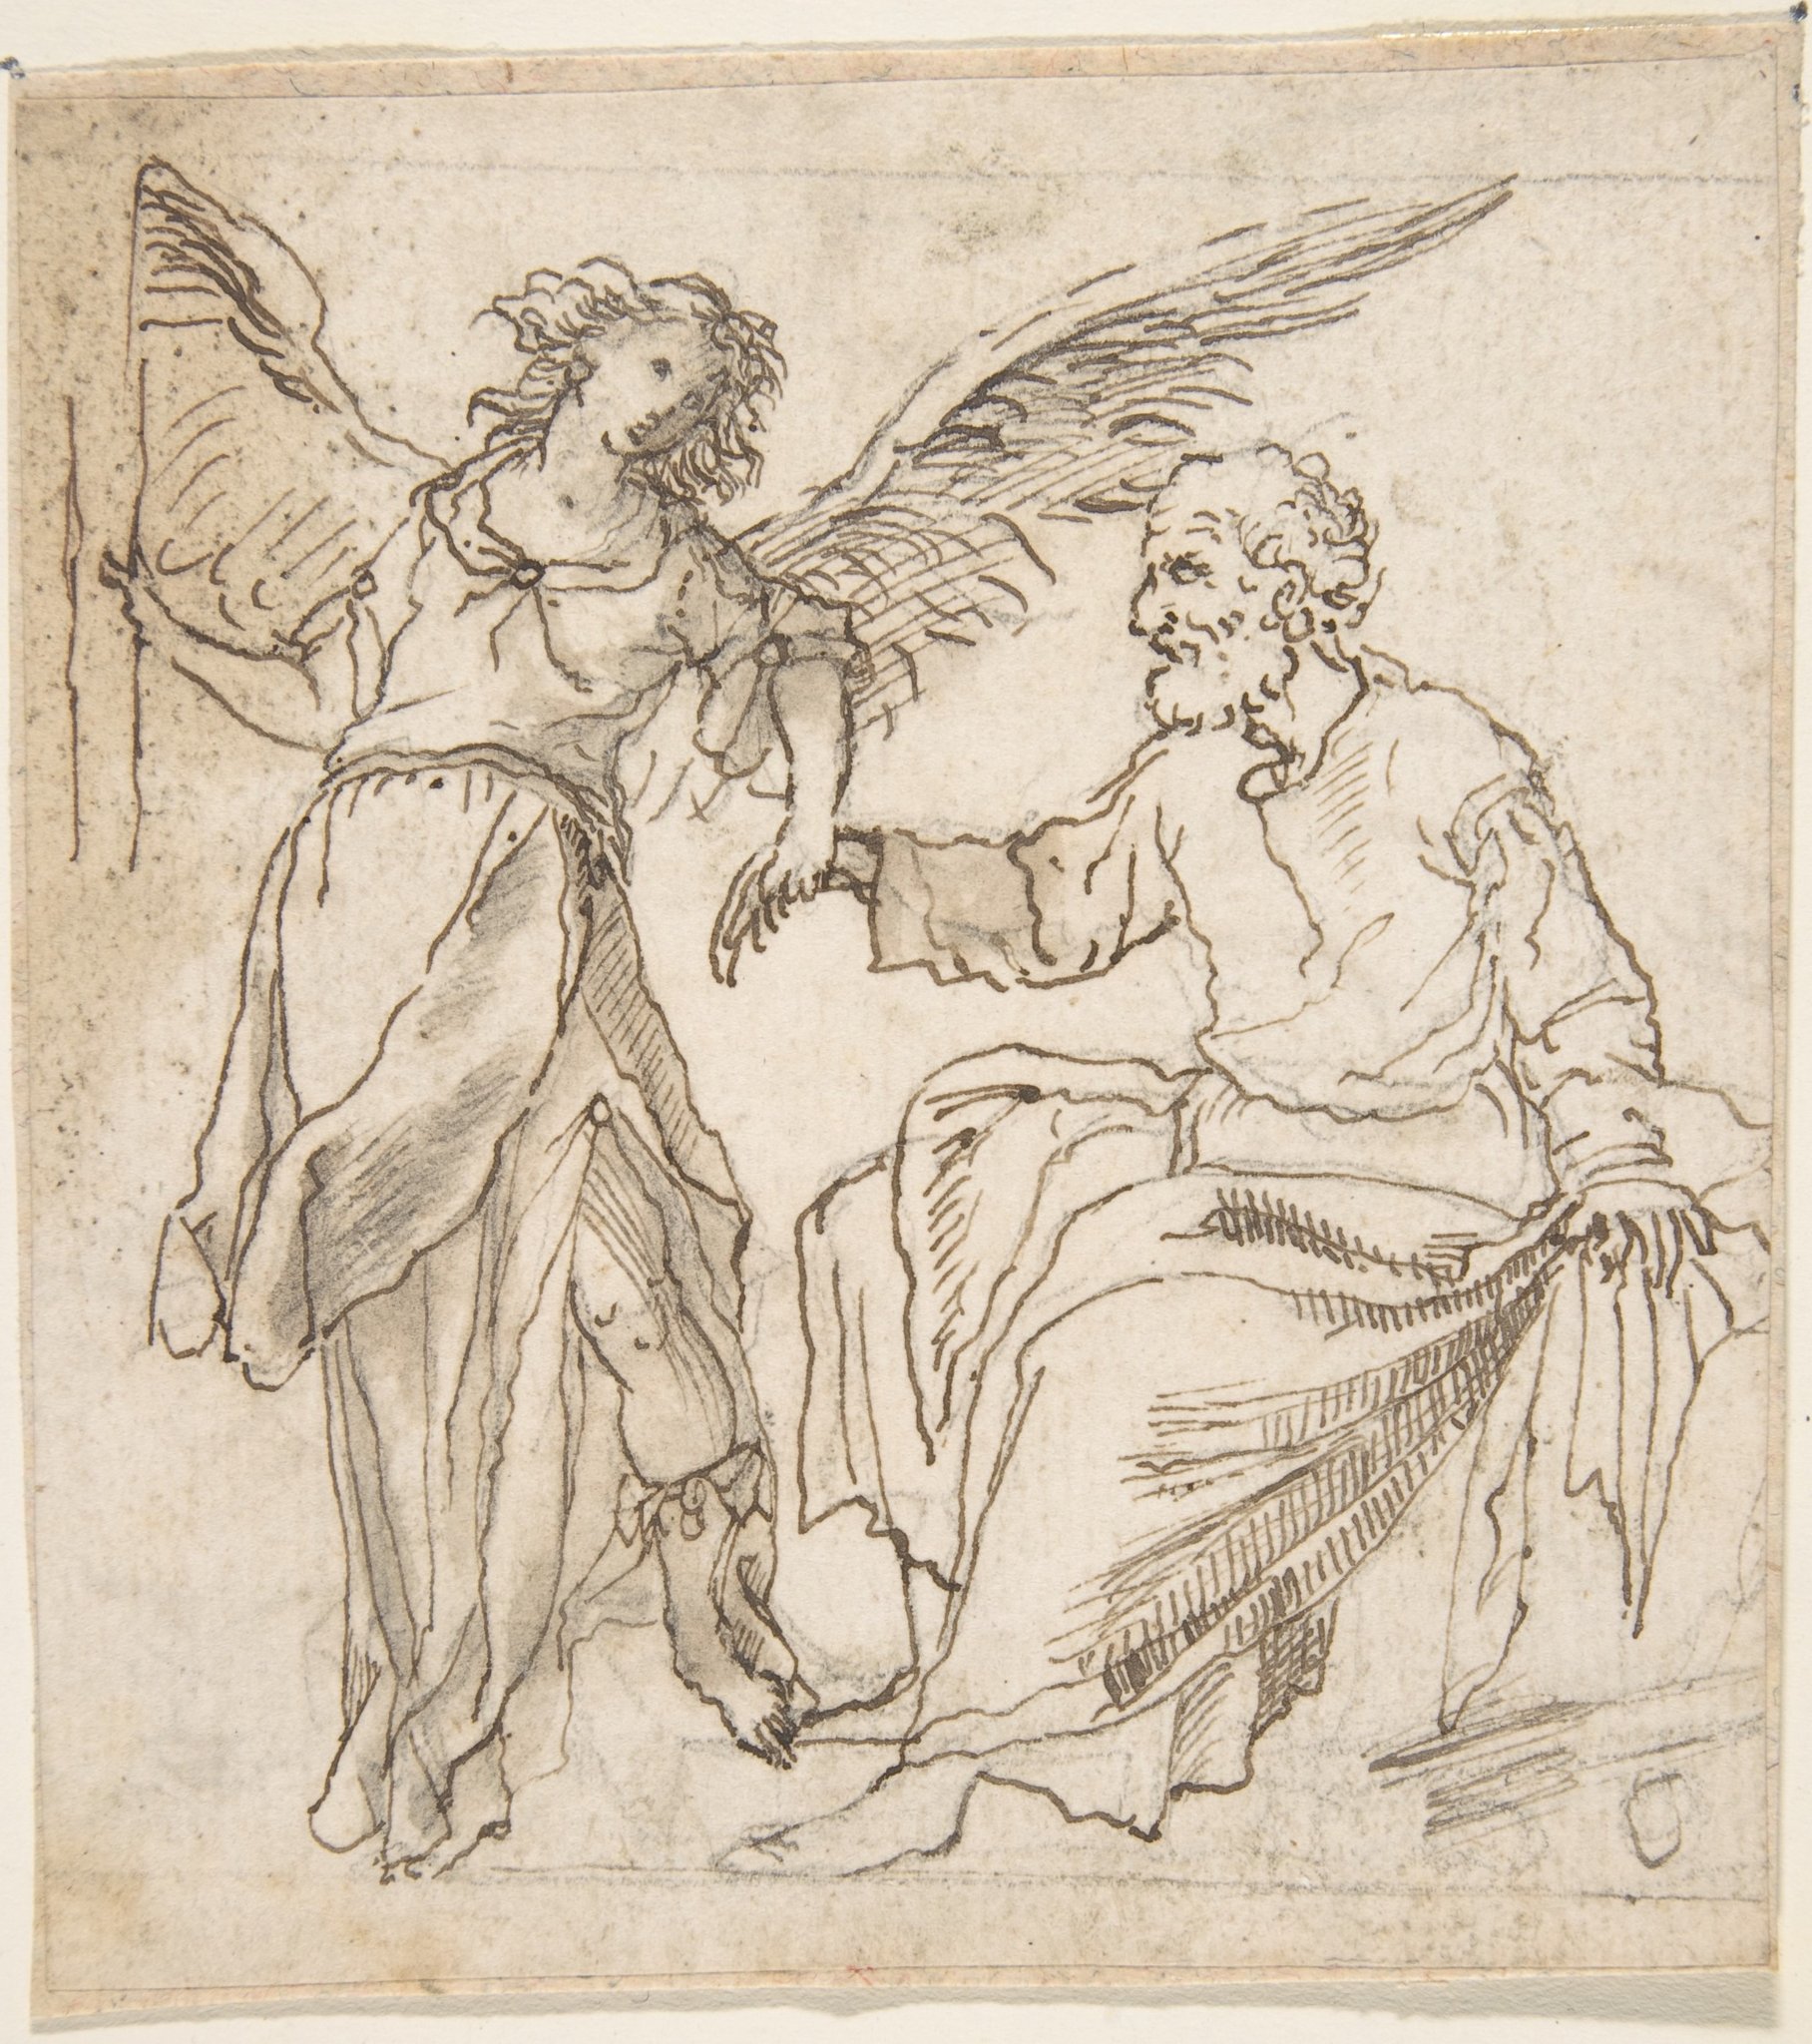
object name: drawing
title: Angel Leading Saint Peter out of Prison (?)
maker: anonymous, spanish, school of seville, 17th century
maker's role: artist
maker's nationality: spanish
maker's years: 1600-1700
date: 1601-1700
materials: chalk, ink, paper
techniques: brush, pen, drawing, wash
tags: angels,saint peter